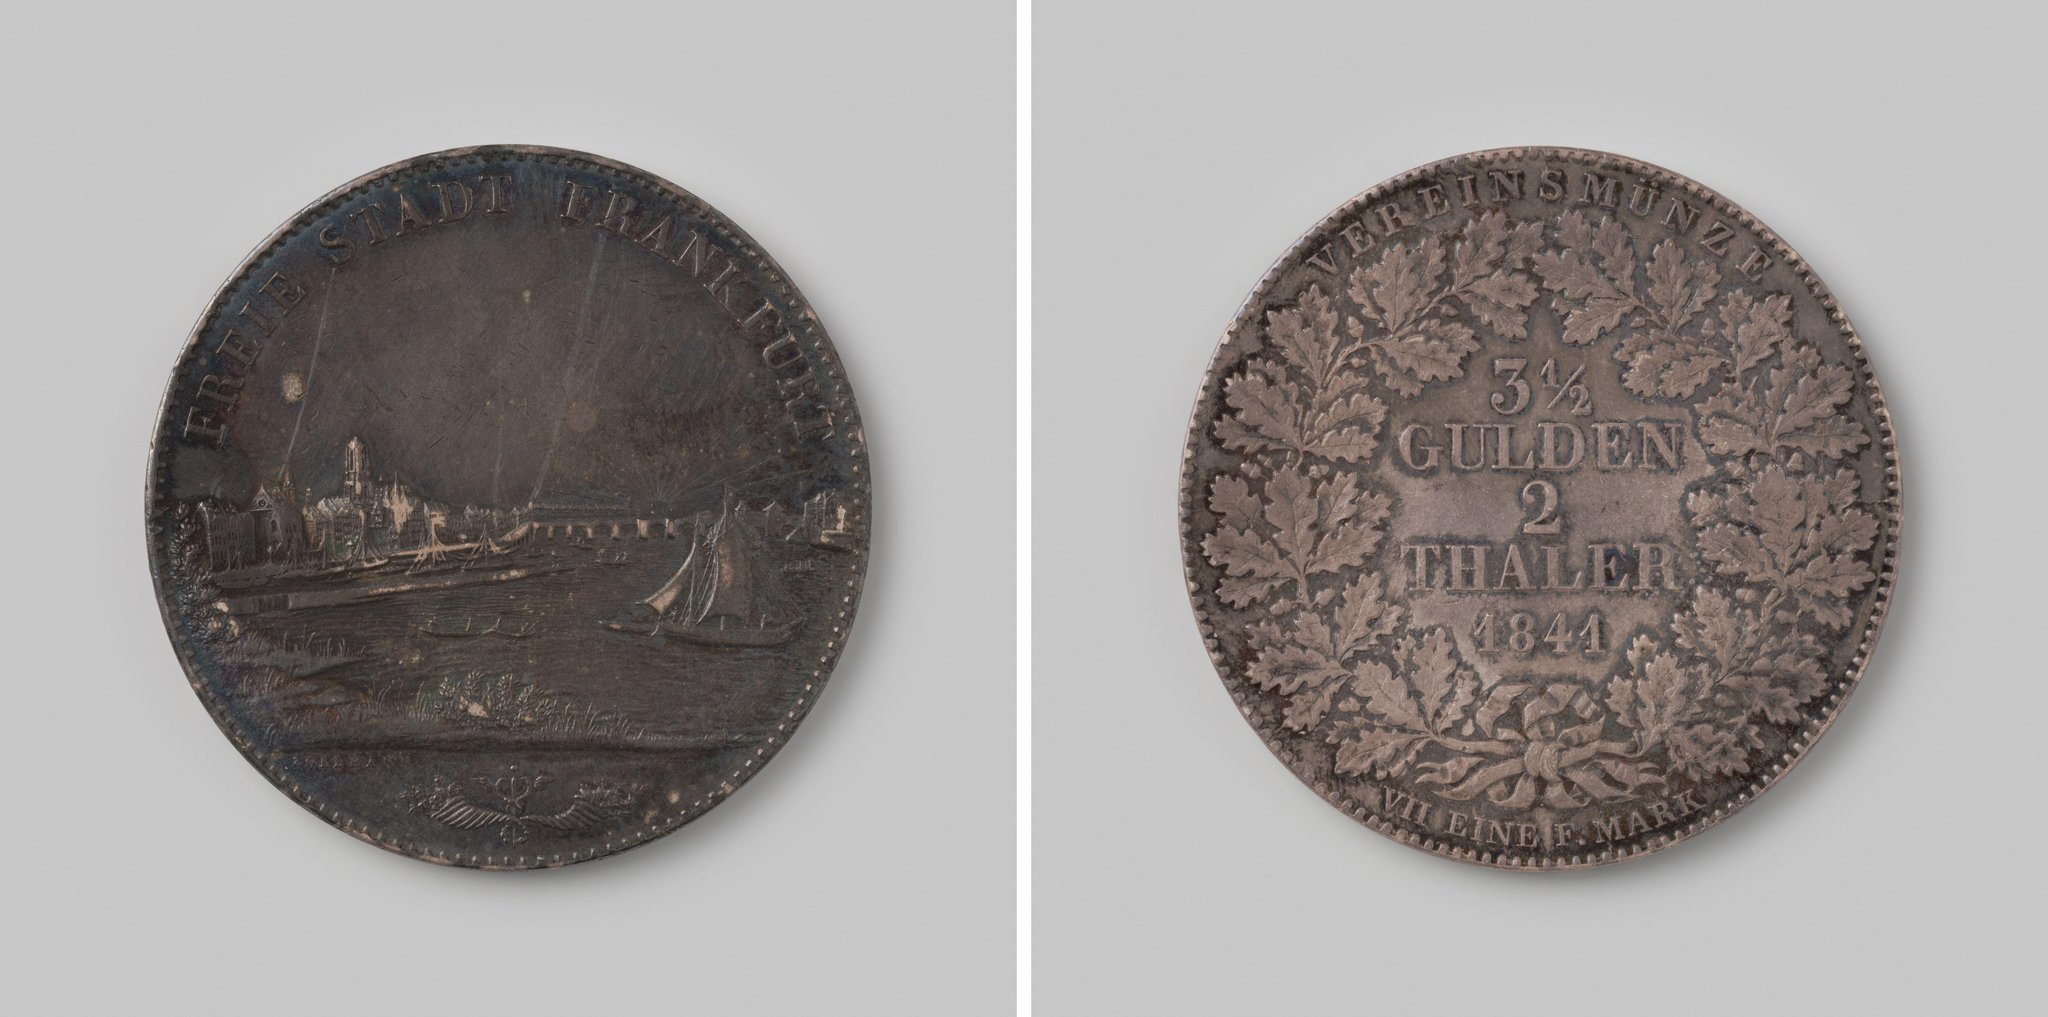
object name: coin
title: Vrije rijksstad Frankfurt am Main, 2 Taler, 1841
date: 1841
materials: silver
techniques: striking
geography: frankfurt am main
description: Zilveren munt. Voorzijde: stadsgezicht met in afsnede twee hoornen des overvloeds, waartussen mercuriusstaf. Keerzijde: binnen twee samengebonden eiketakken in vier regels waarde-aanduidingen, waaronder jaartal. Randschrift.